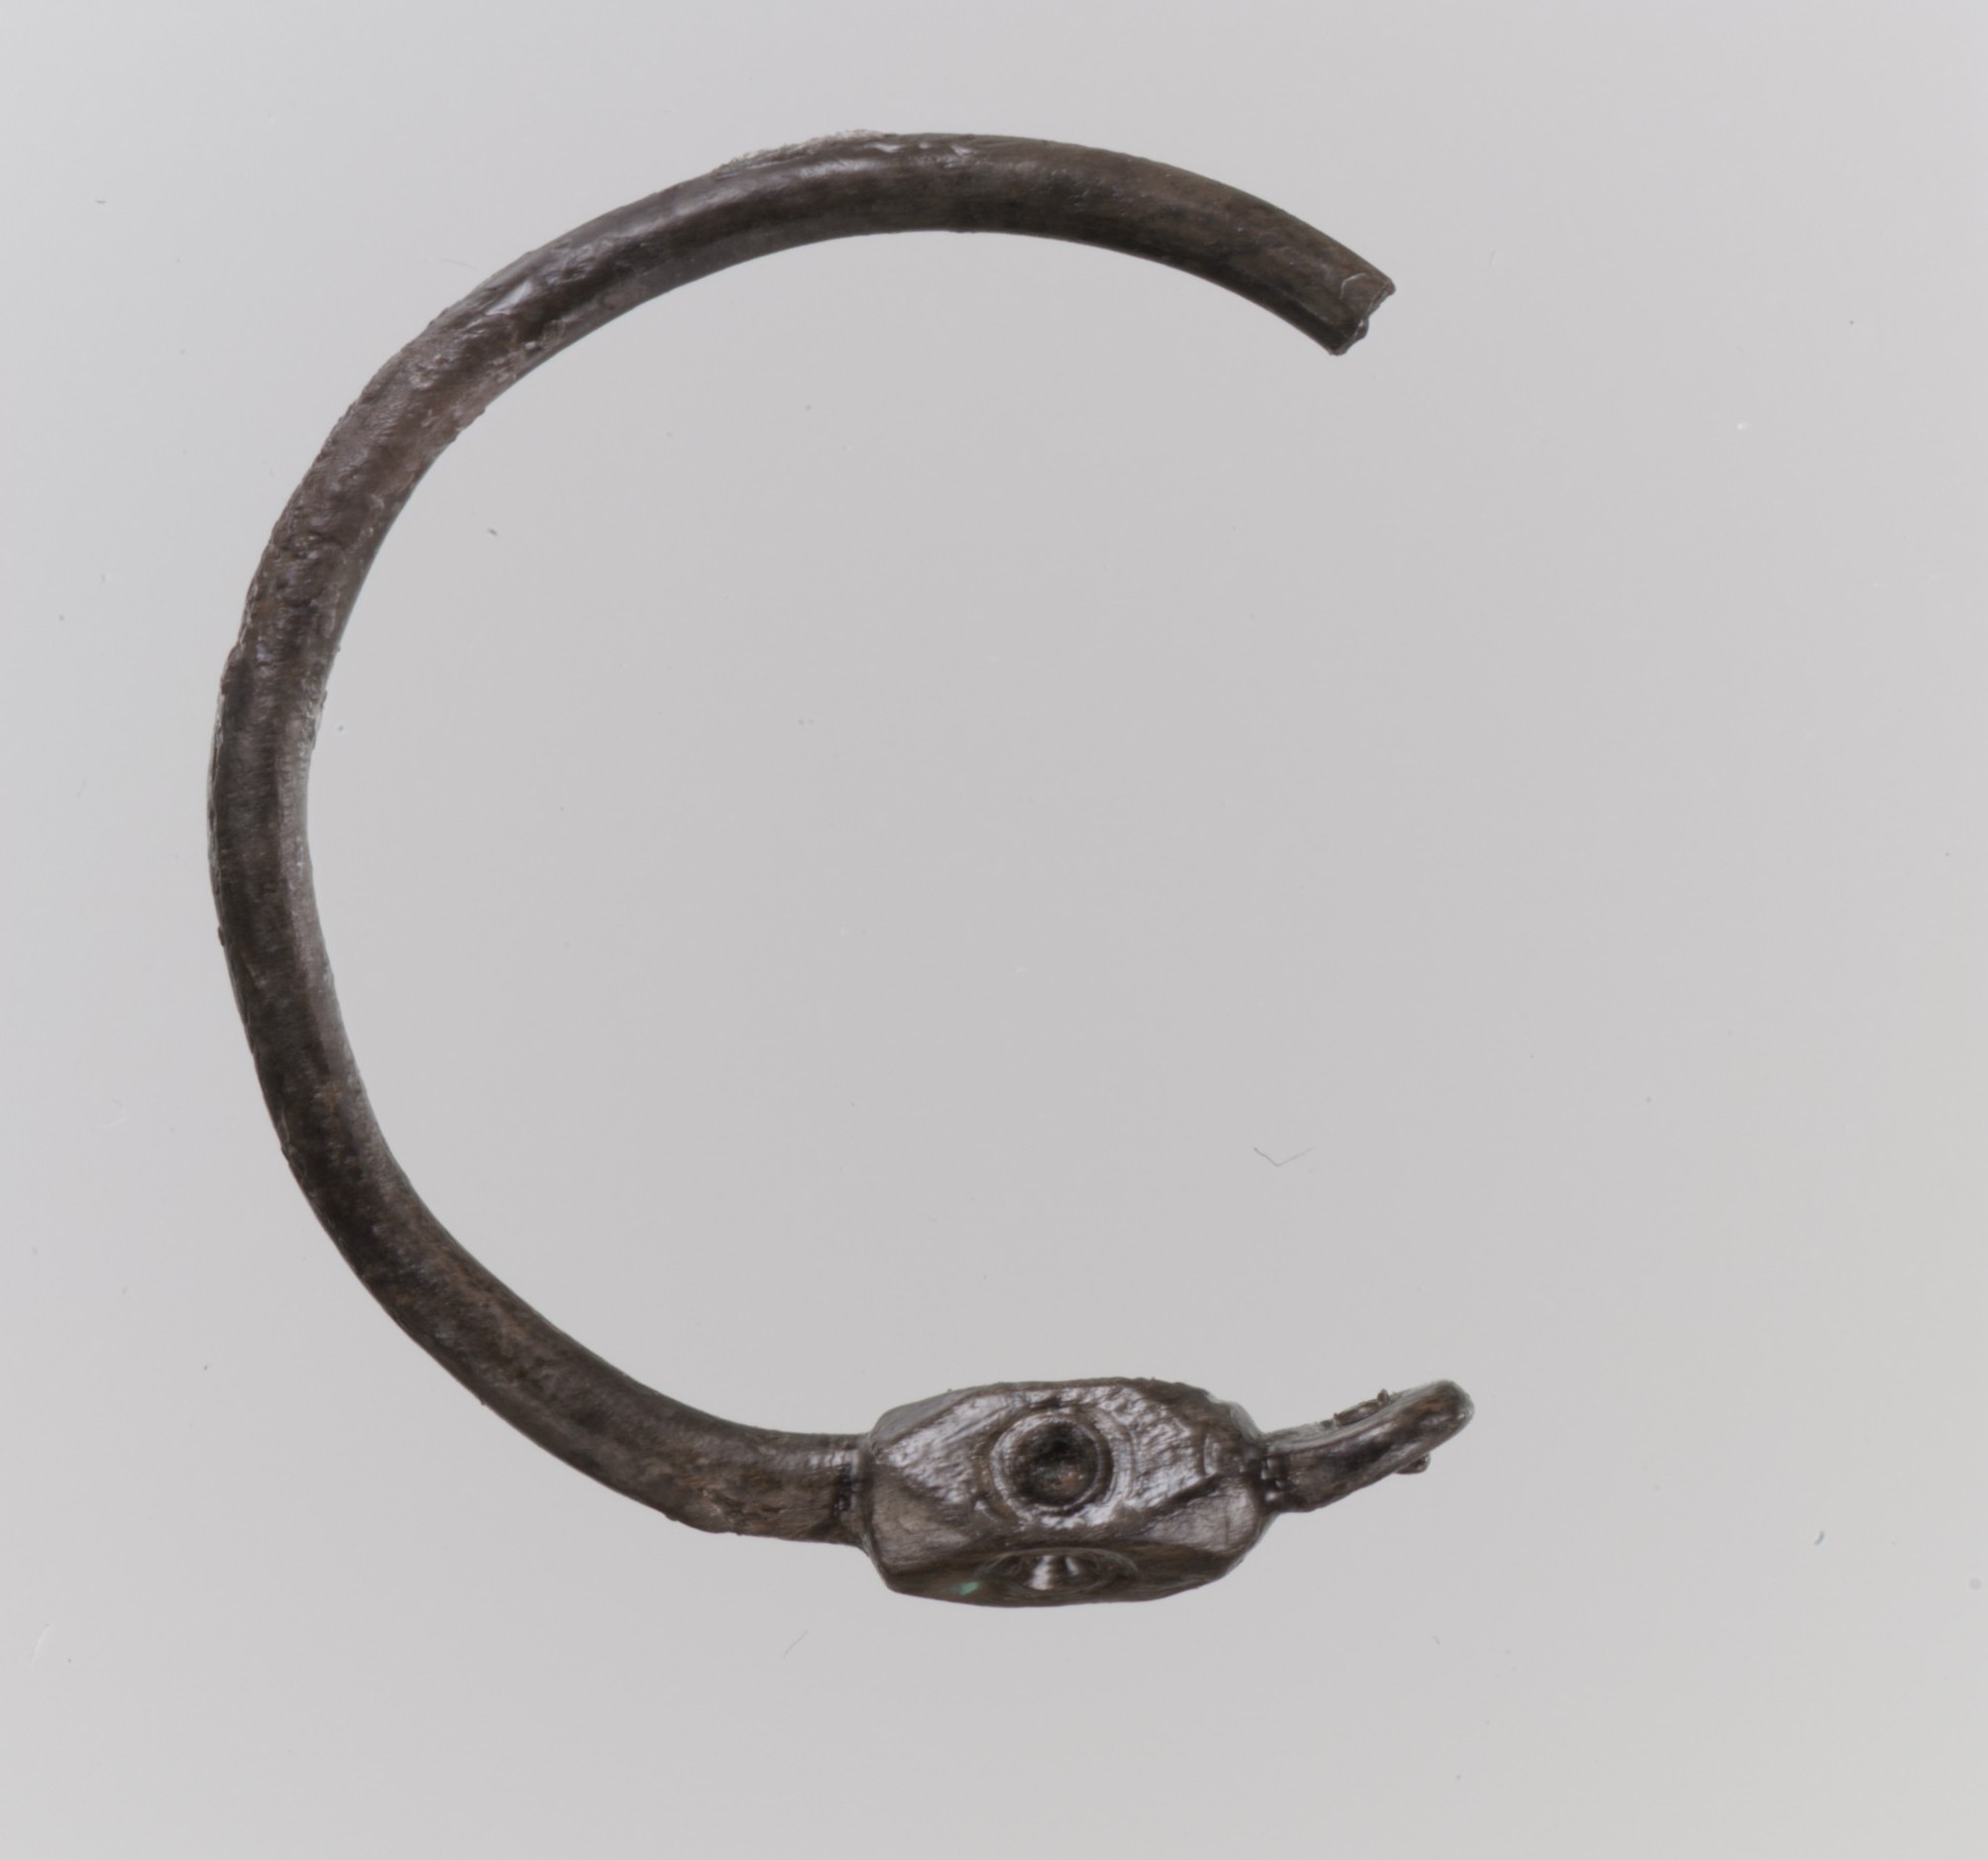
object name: earring fragment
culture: frankish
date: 601-700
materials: silver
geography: germany